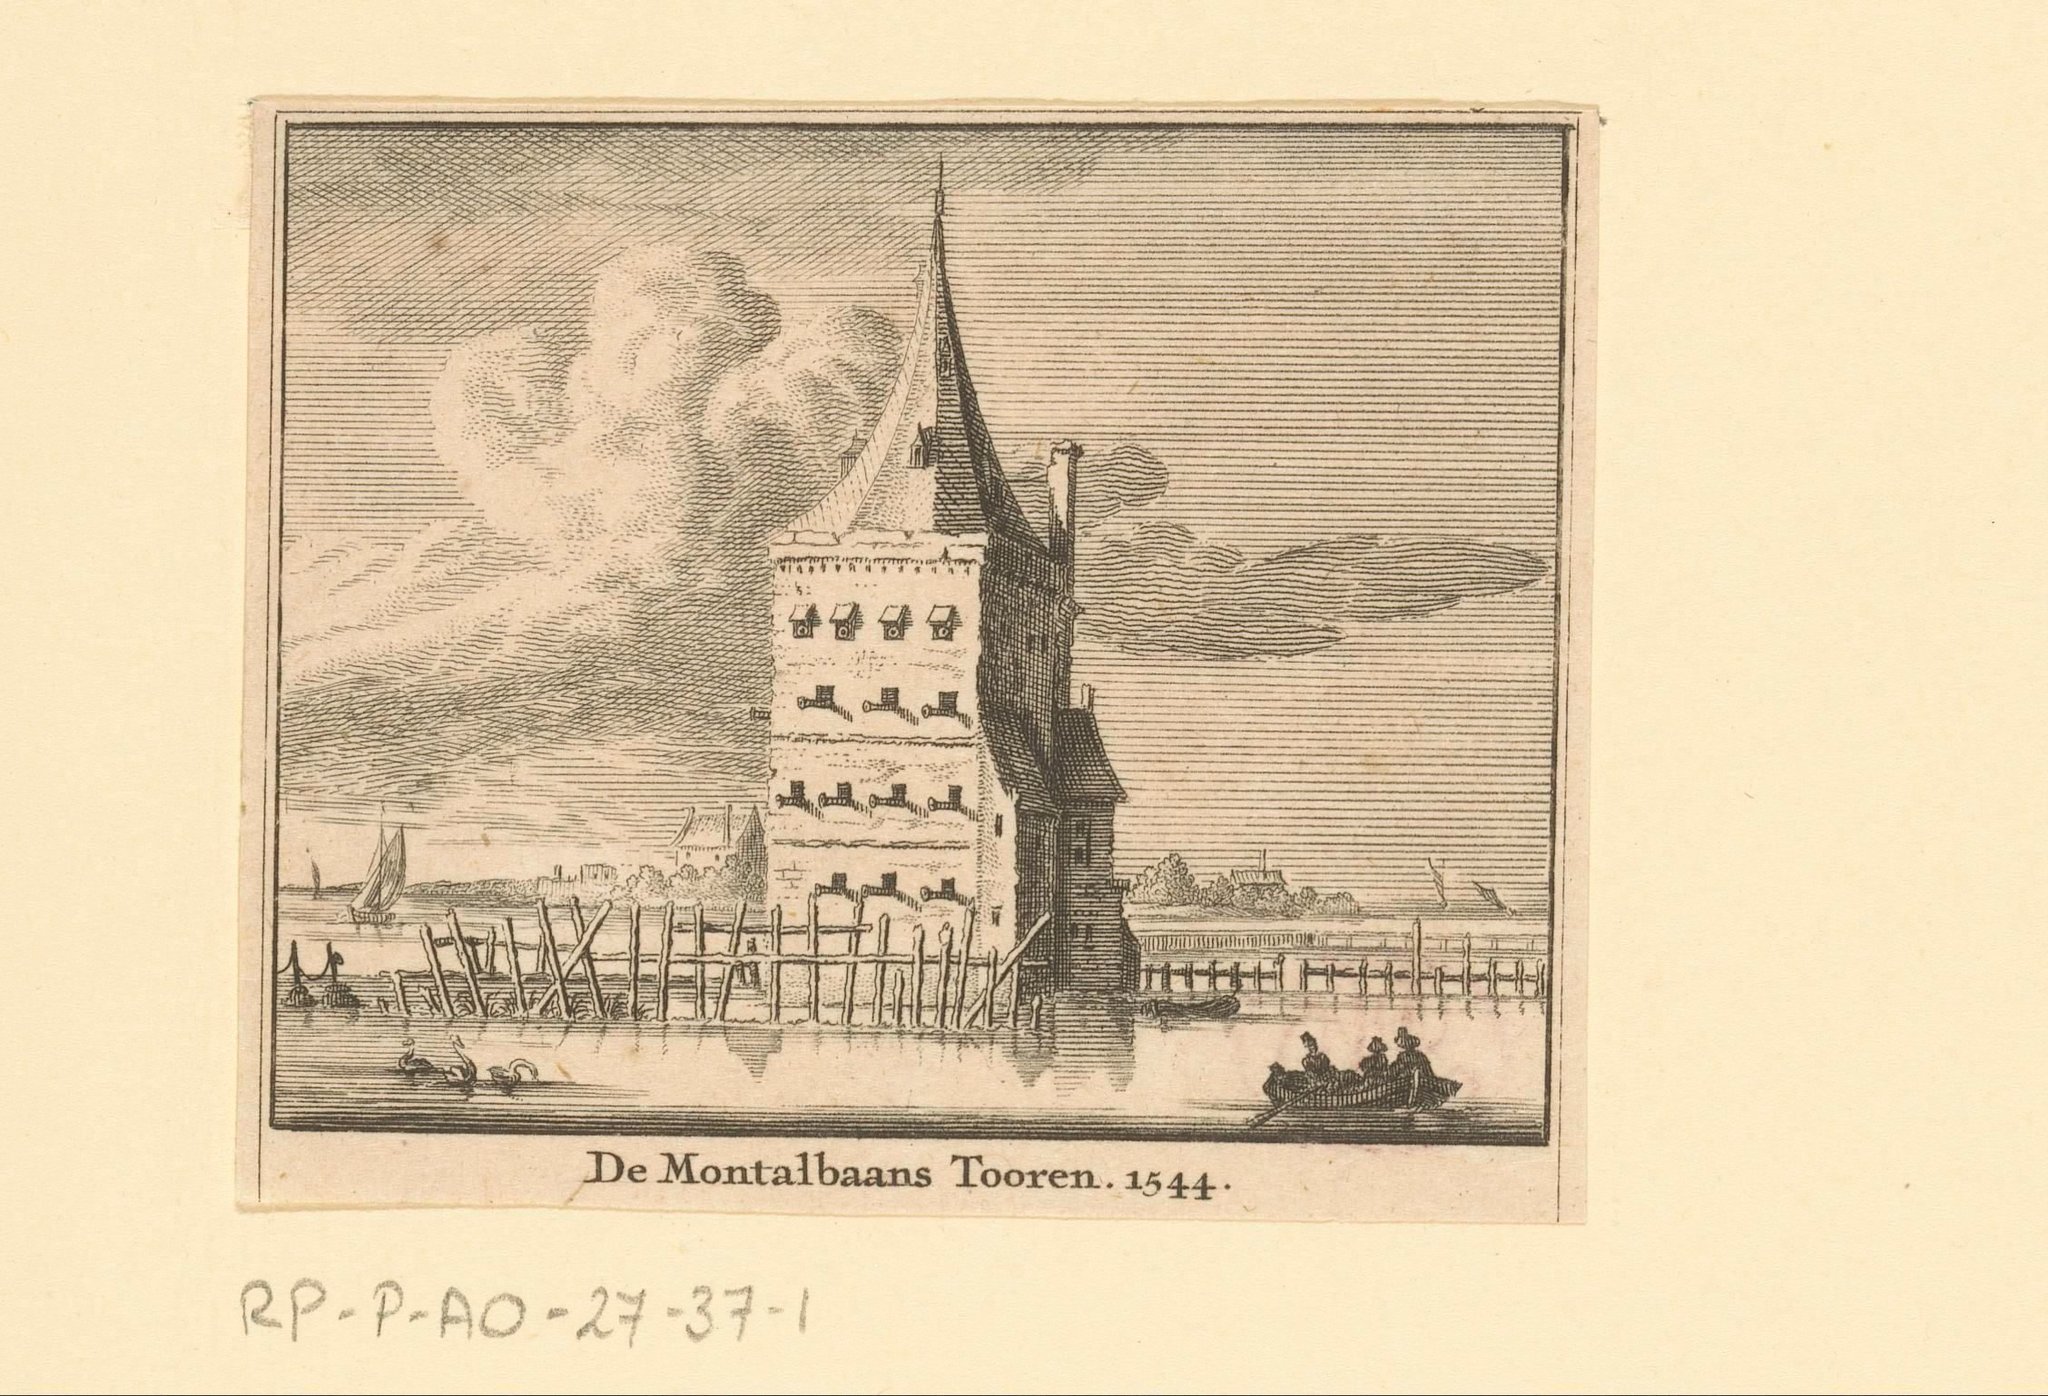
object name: print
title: Gezicht op de Montelbaanstoren te Amsterdam, 1544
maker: jan goeree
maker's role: draughtsman, print maker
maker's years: 1670-1731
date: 1723-1738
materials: paper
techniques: engraving, etching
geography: amsterdam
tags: towers ~ fortified city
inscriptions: collector's mark: Lugt 195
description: Prent ook gebruikt in: Willink, Daniël. Amsterdamsche Buitensingel nevens de omleggende dorpen, opgeheldert door aanteekeningen over veele voornaame geschiedeniszen: met afbeeldingen (…) / Daniël Willinks Amsterdamsche Buitensingel. Amsterdam: Andries van Damme, 1723. En in: Willink, Daniël. Amsterdamsche Buitensingel nevens de omleggende dorpen, opgeheldert door aanteekeningen over veele voornaame geschiedenissen: met afbeeldingen (…) / Daniël Willinks Amsterdamsche Buitensingel. Amsterdam: Arend van Huyssteen, 1738.